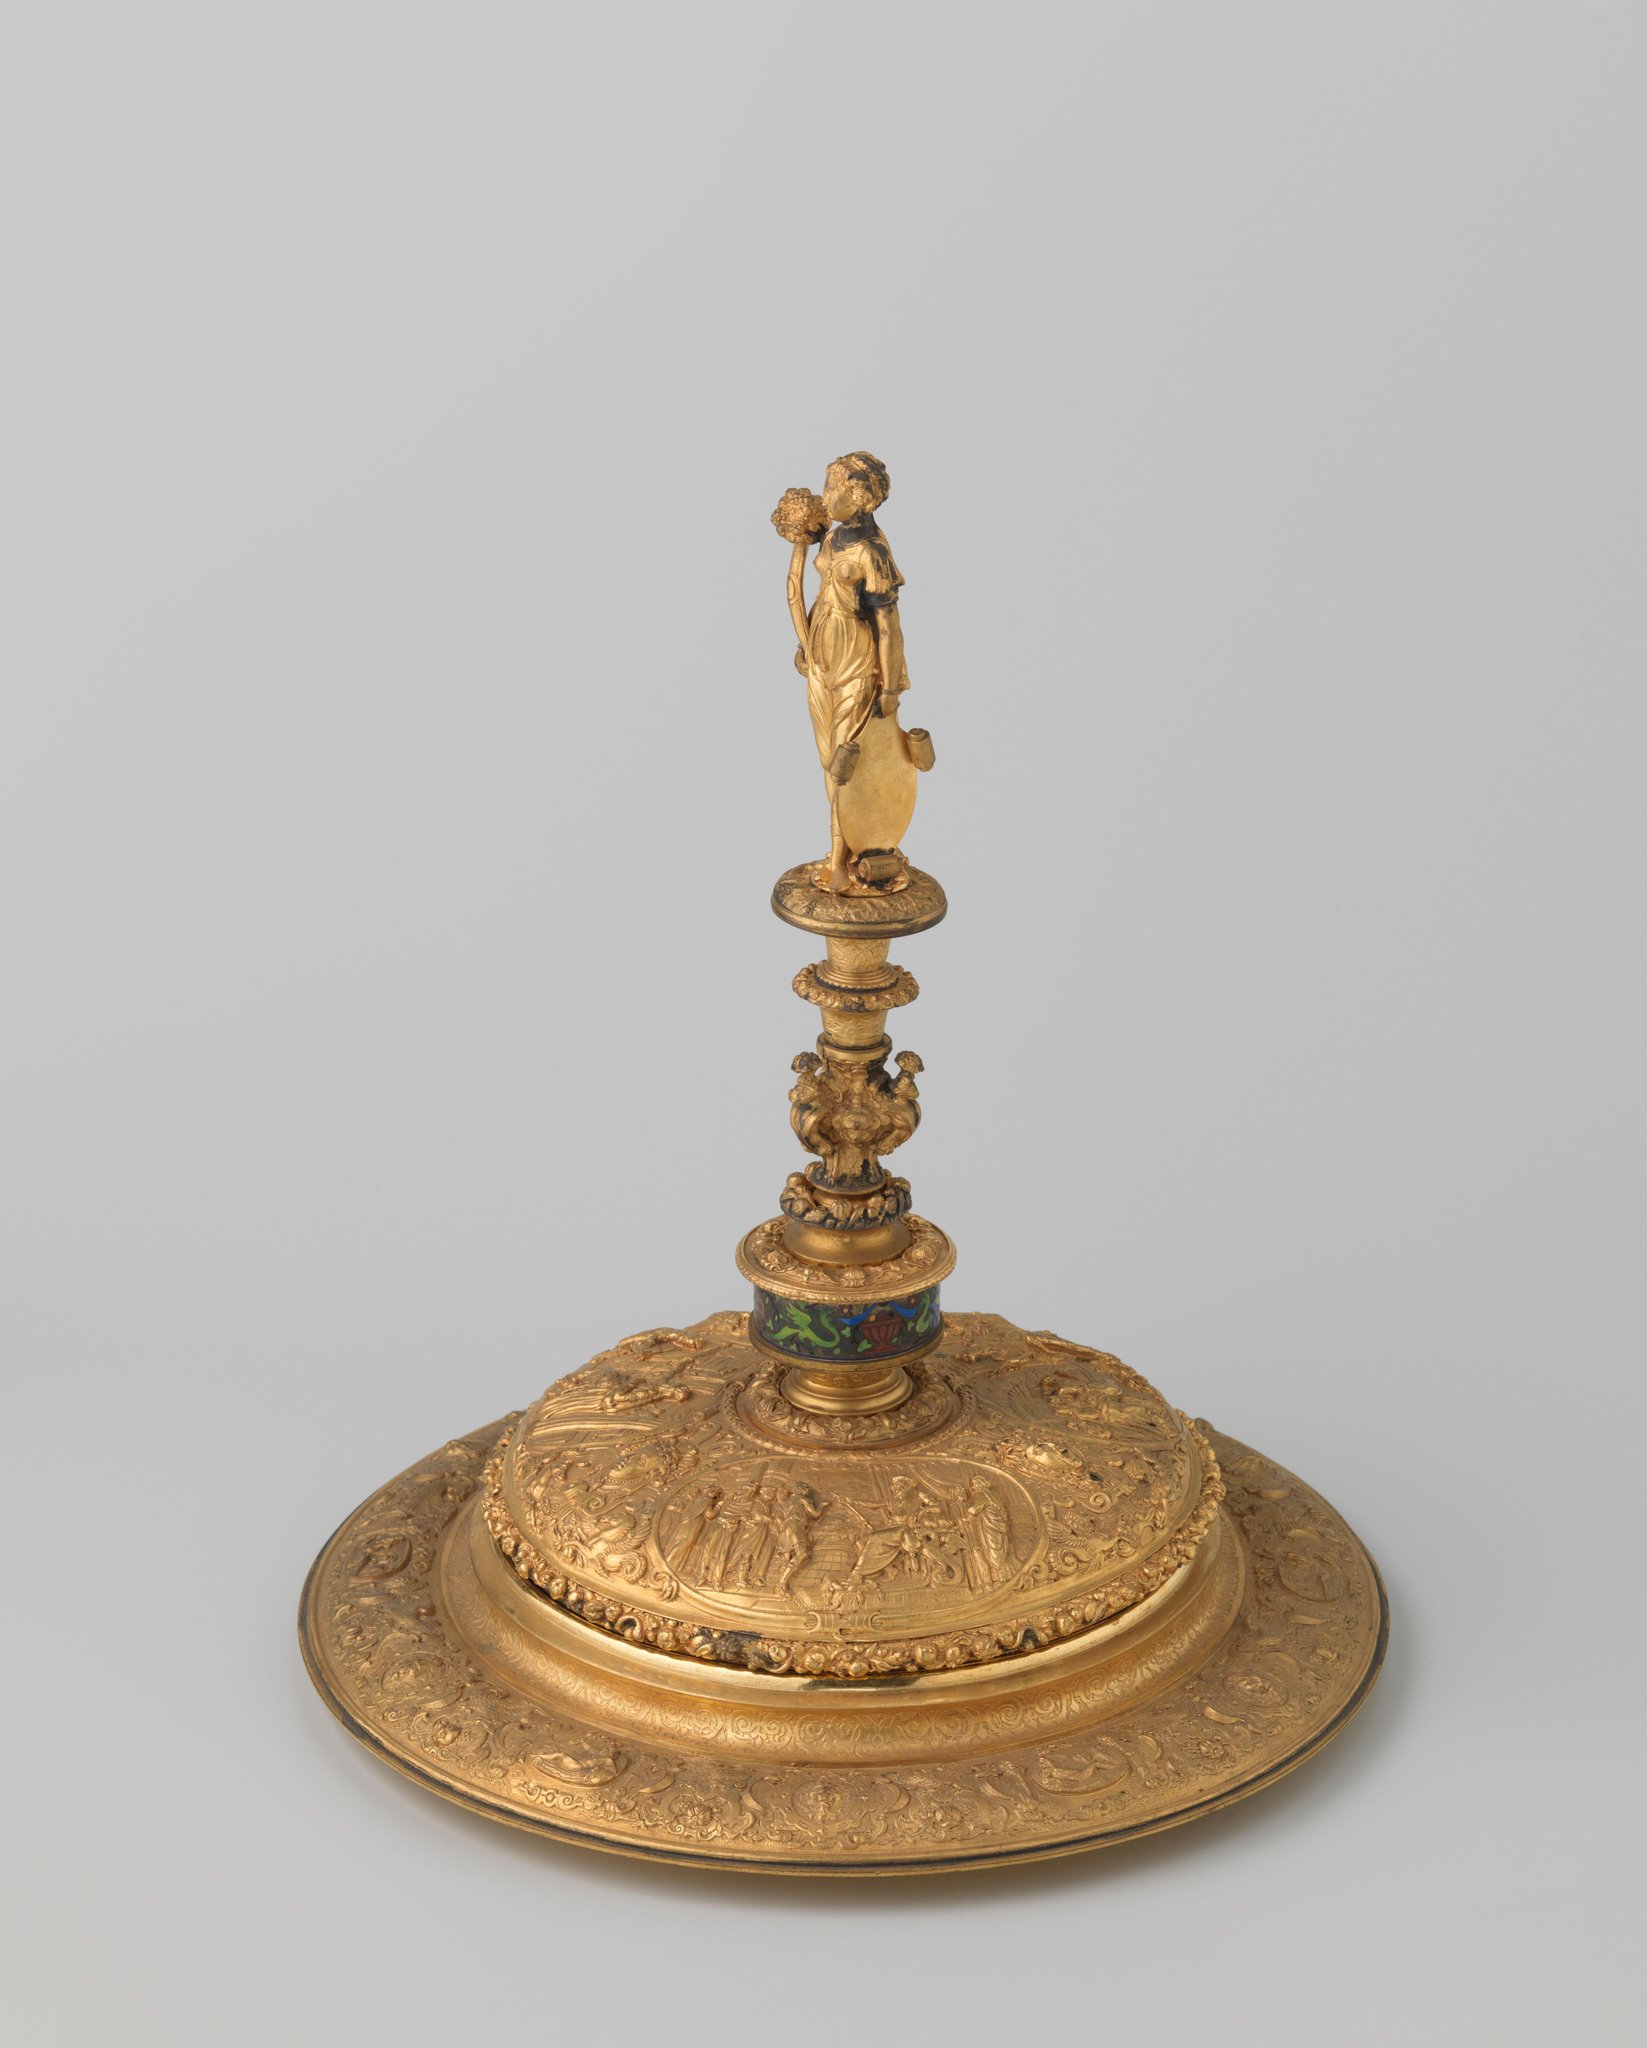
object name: lid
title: Galvanoplastische reproductie van een deksel horend bij een bokaal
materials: copper, silver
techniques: gilding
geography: london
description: Galvanoplastische reproductie van een deksel horend bij een bokaal (BK-NM-5317-1). Op het deksel drie panelen bijbelse scènes in laagreliëf. Verguld.